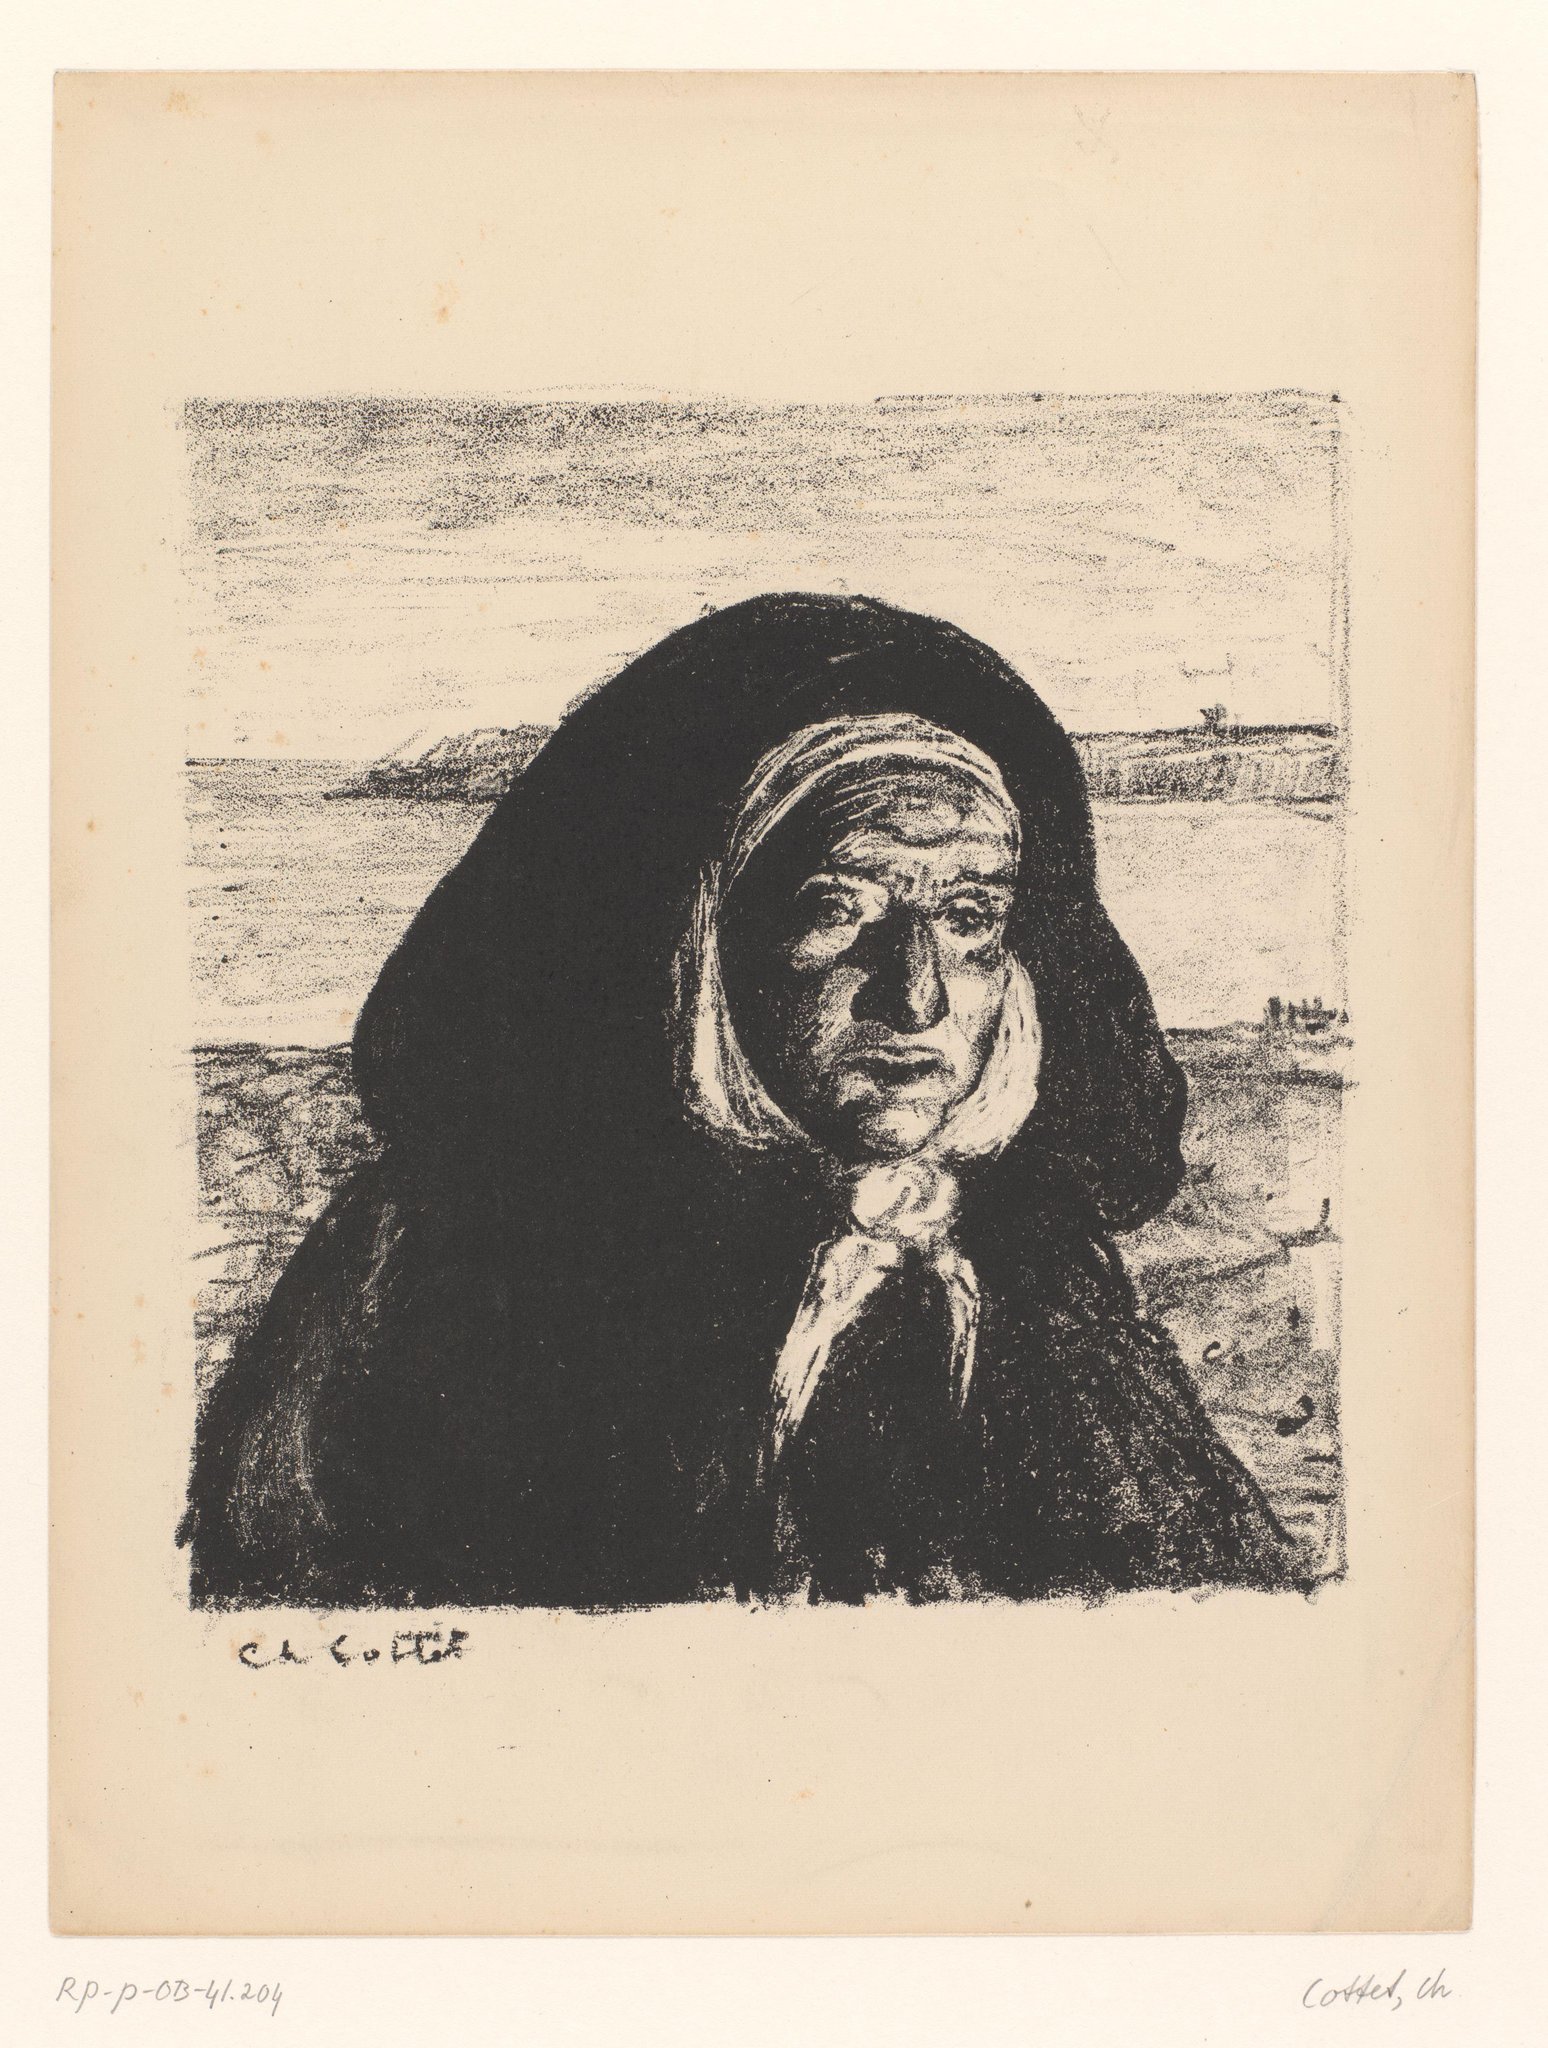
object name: print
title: Bretonse oude vrouw met kap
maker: charles cottet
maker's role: print maker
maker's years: 1863-1925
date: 1895-1914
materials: paper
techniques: lithography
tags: old woman, head-gear: cap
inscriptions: number: ‘R.13’